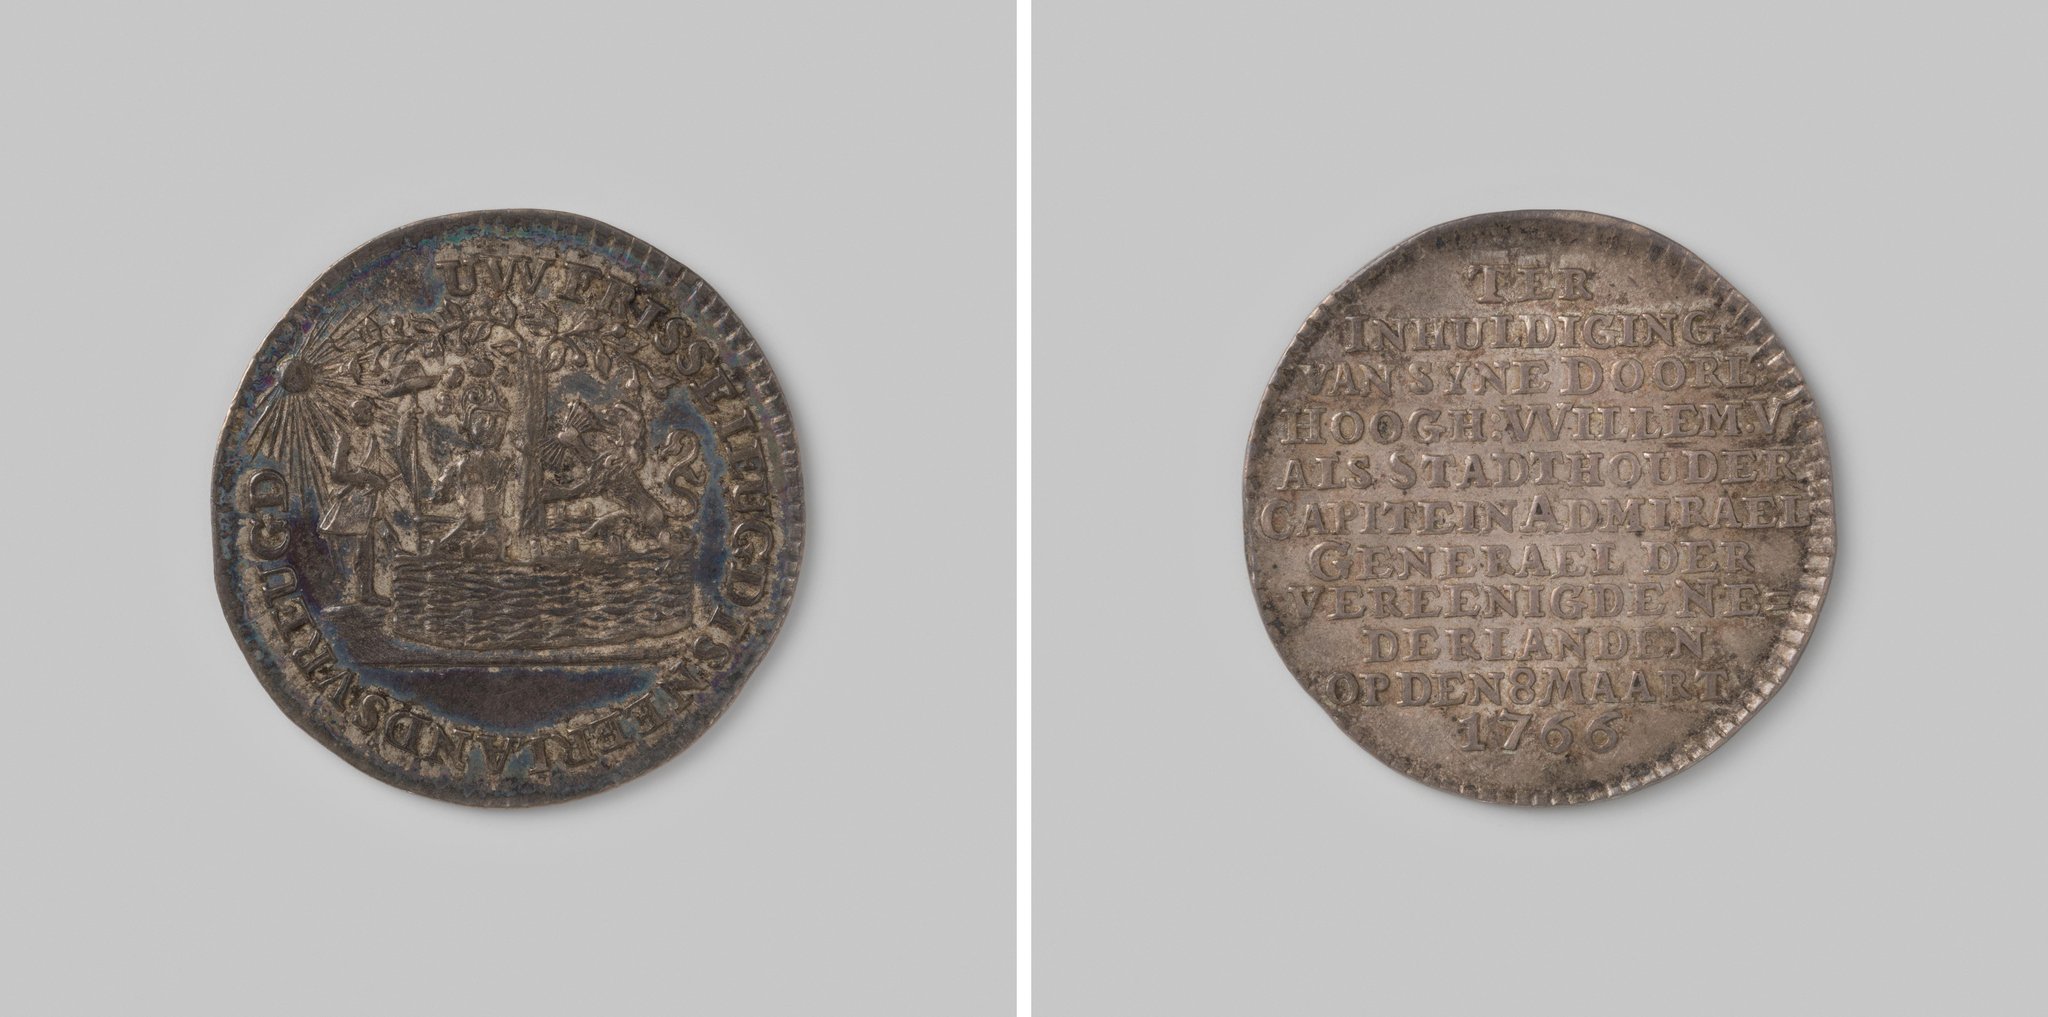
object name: history medal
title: Inhuldiging van stadhouder prins Willem V 1766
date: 1766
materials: silver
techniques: striking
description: Zilveren penning, op de voorzijde een Hollandse tuin waarin Nederlandse Maagd, Nederlandse leeuw en oranjeboom waarin links Willem V, zonder degen, binnentreedt, met omschrift, op de keerzijde elf regels tekst.